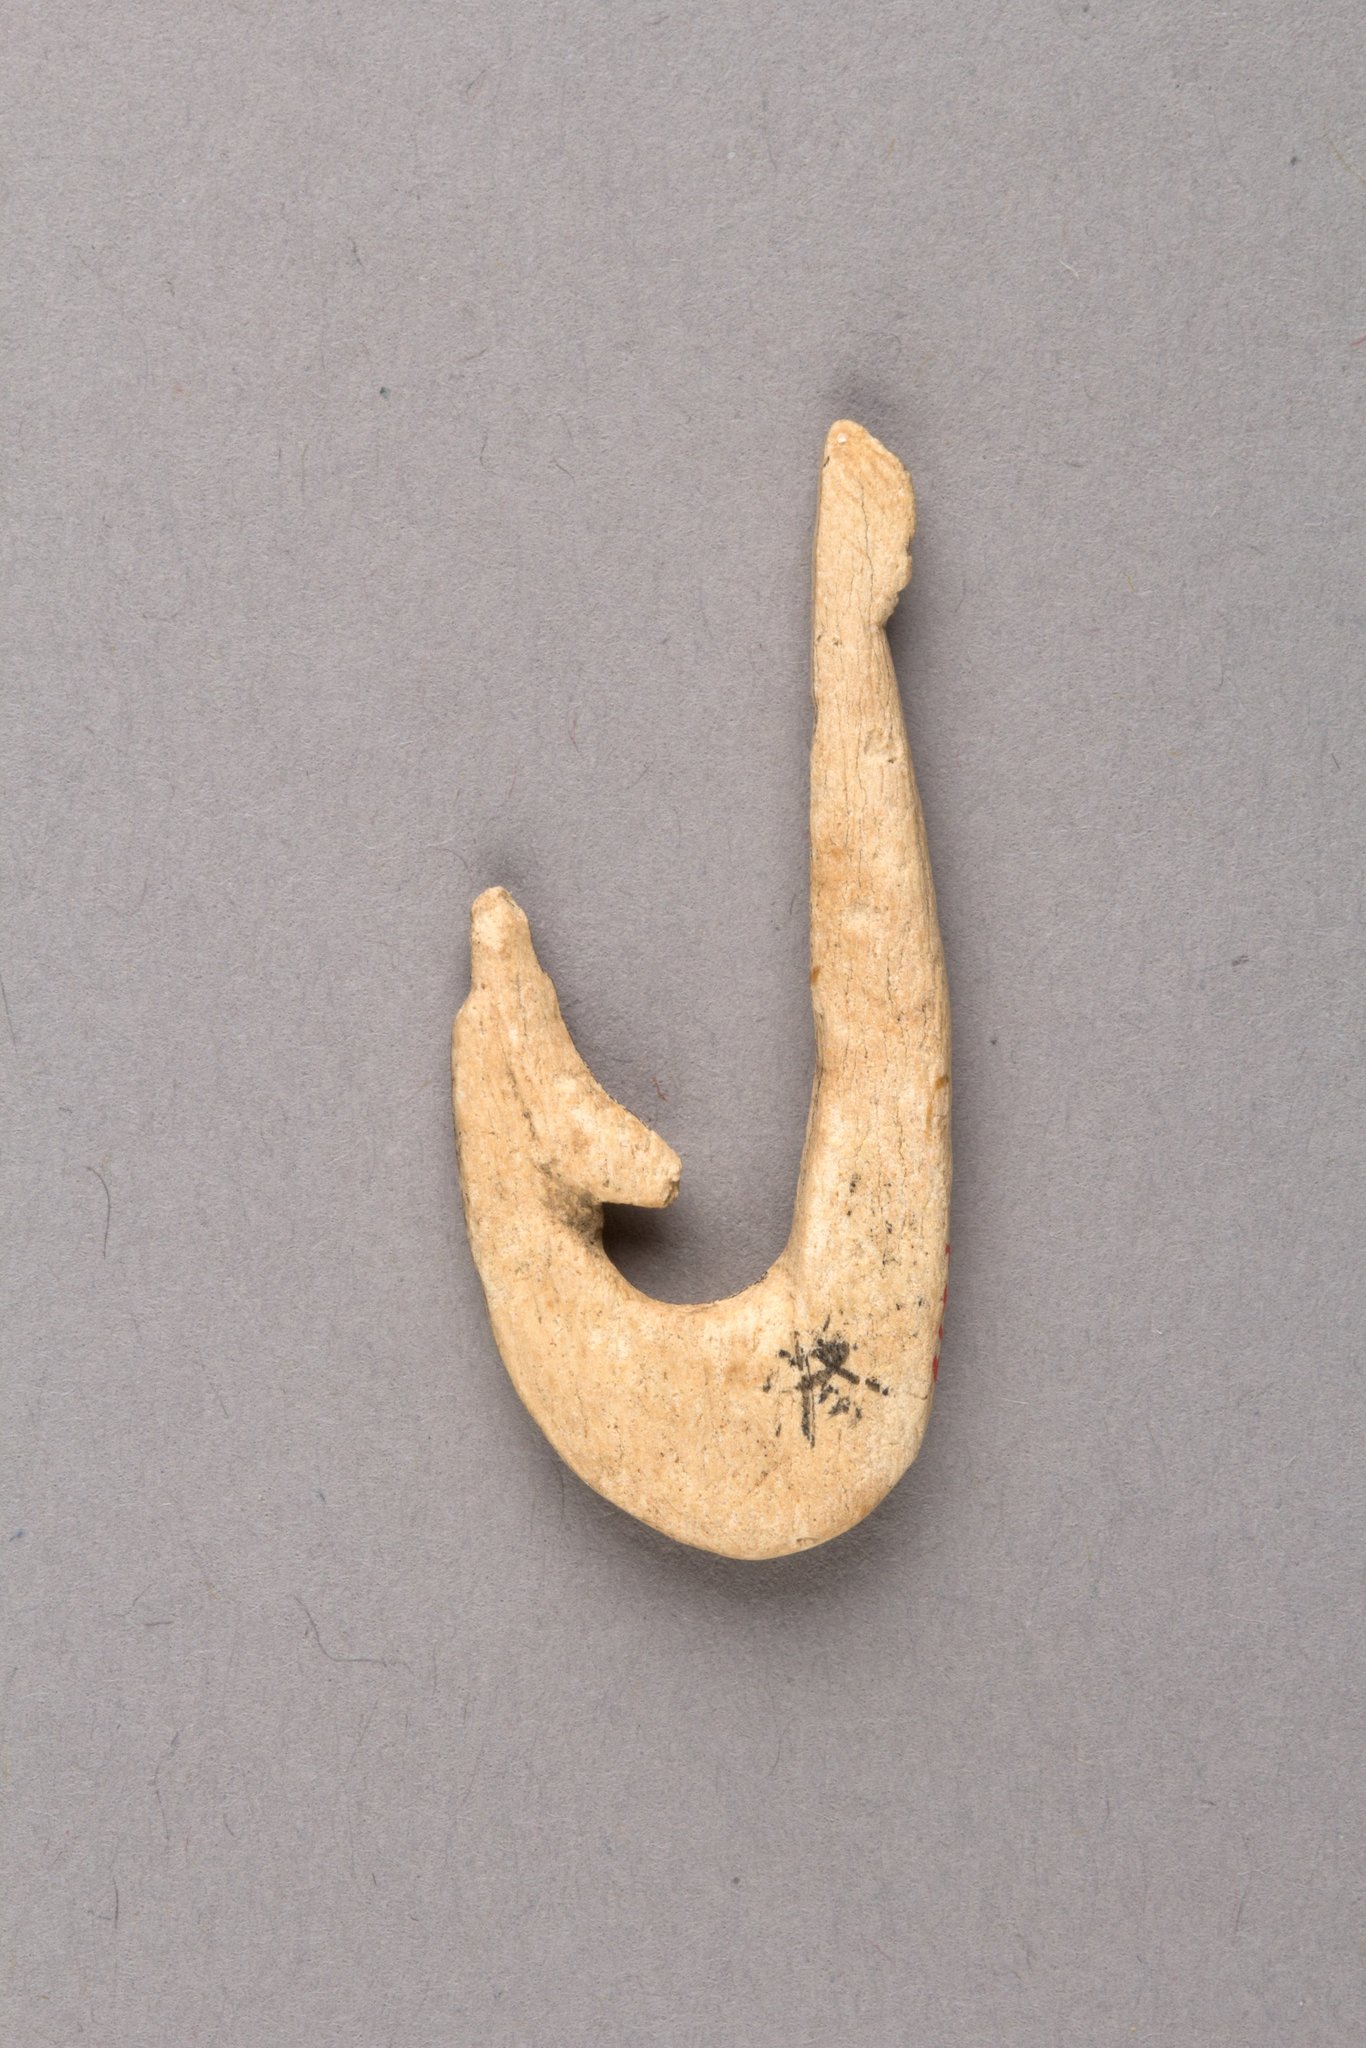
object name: fish hook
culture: japanese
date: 1000-300 BCE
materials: bone